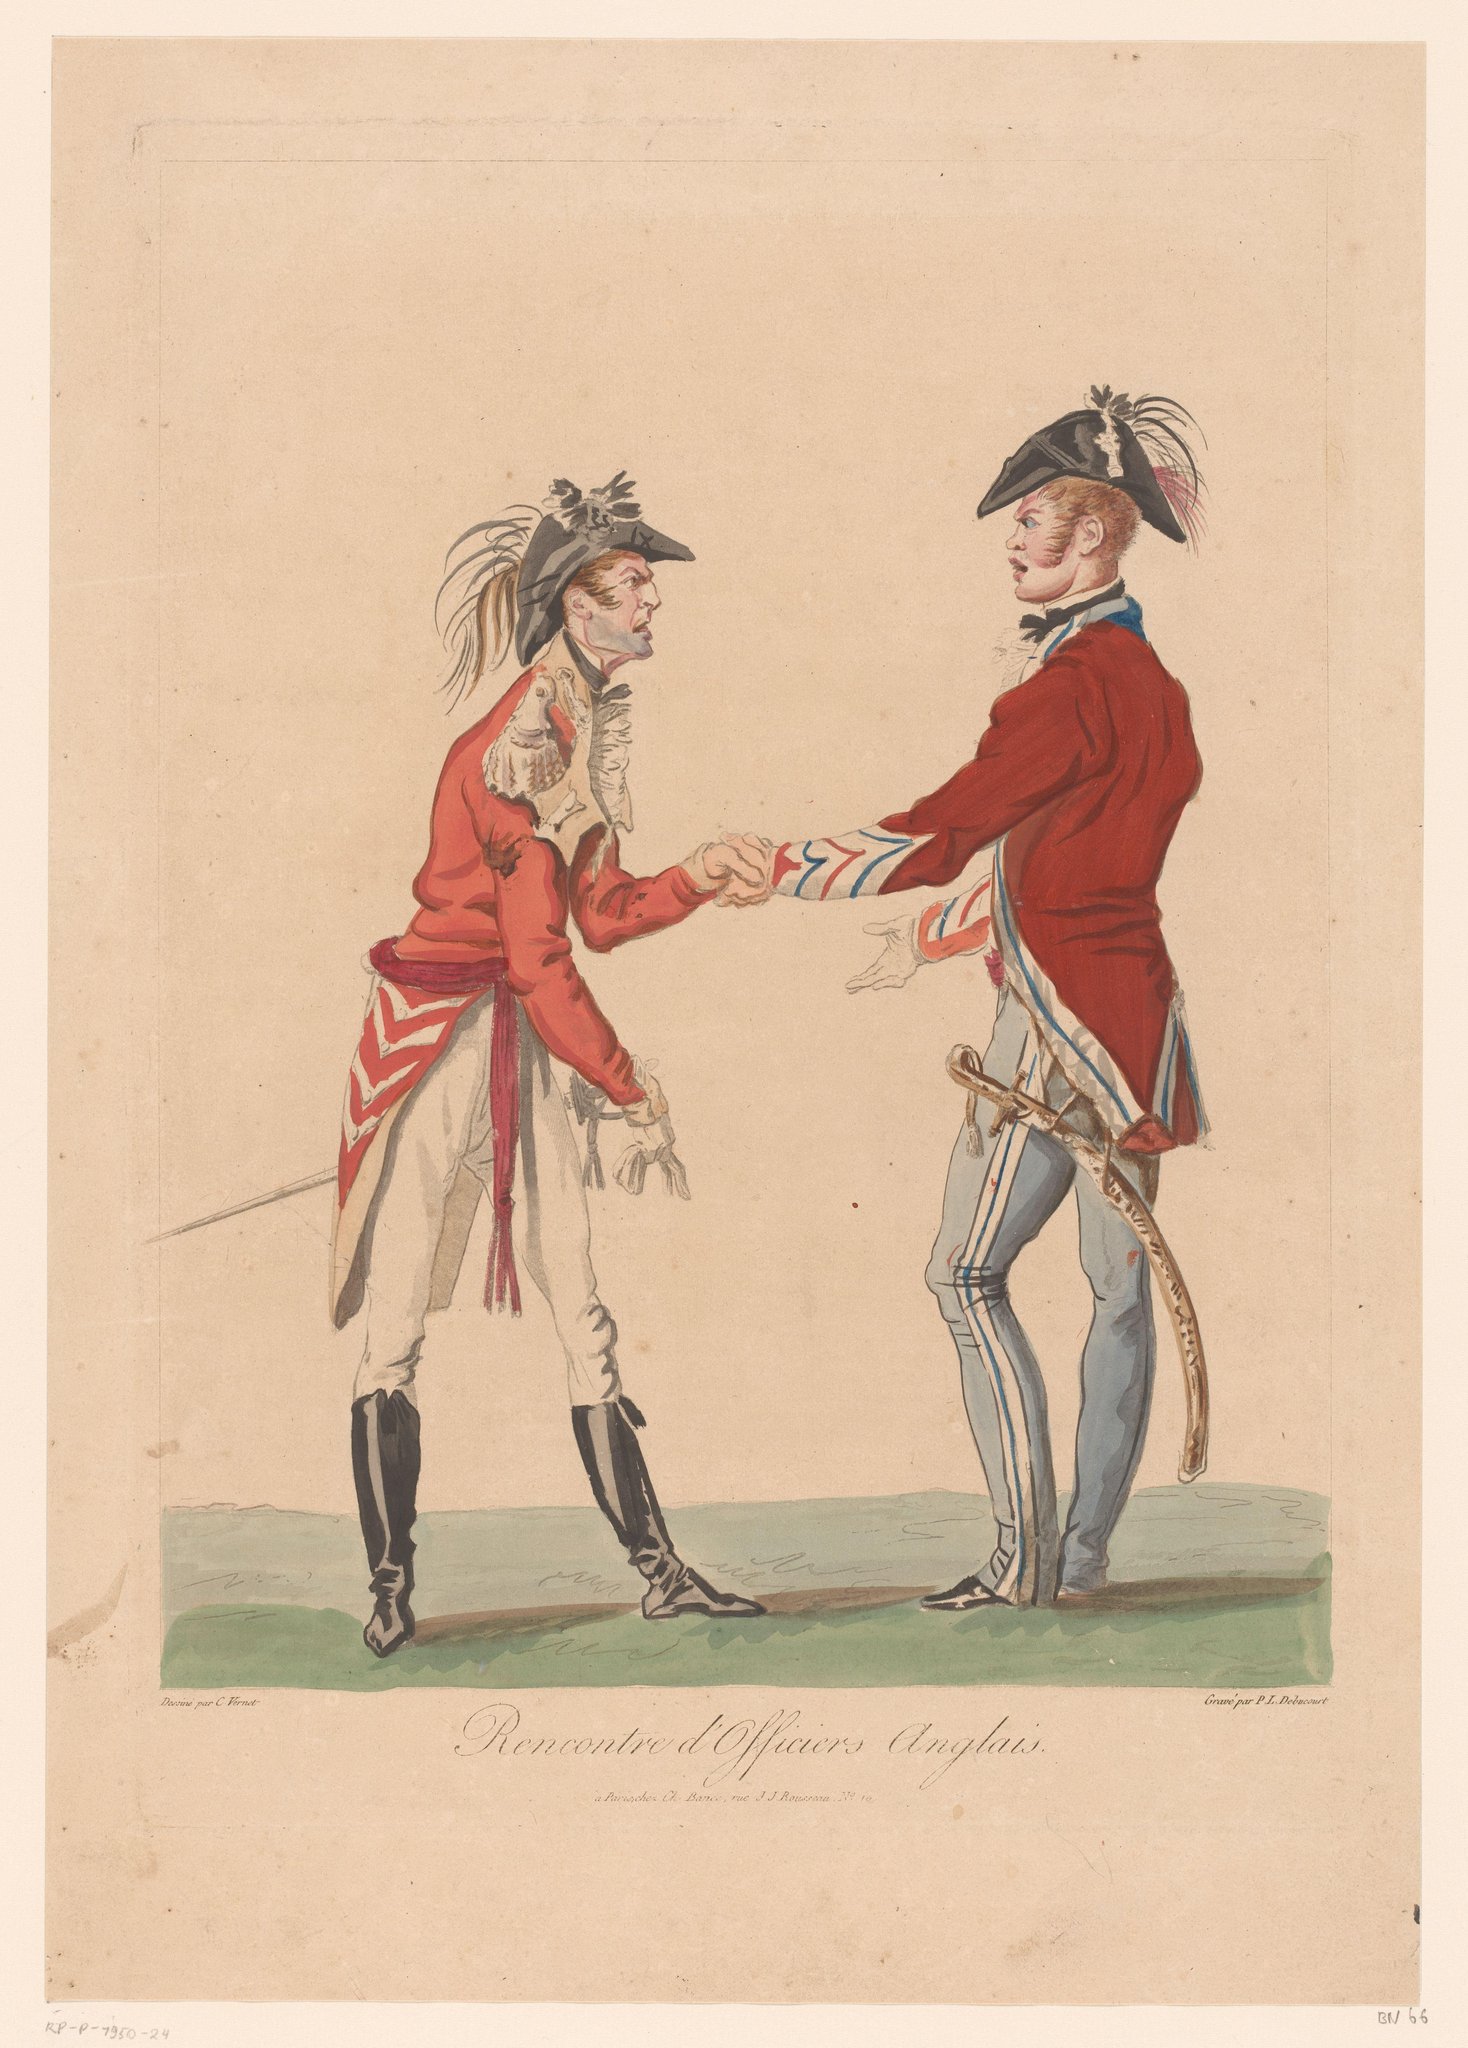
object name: print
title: Kostuumprenten van Debucourt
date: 1814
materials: paper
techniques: aquatint, hand coloring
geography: france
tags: shaking hands, 'dextrarum junctio', officer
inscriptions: collector's mark: Lugt 2228